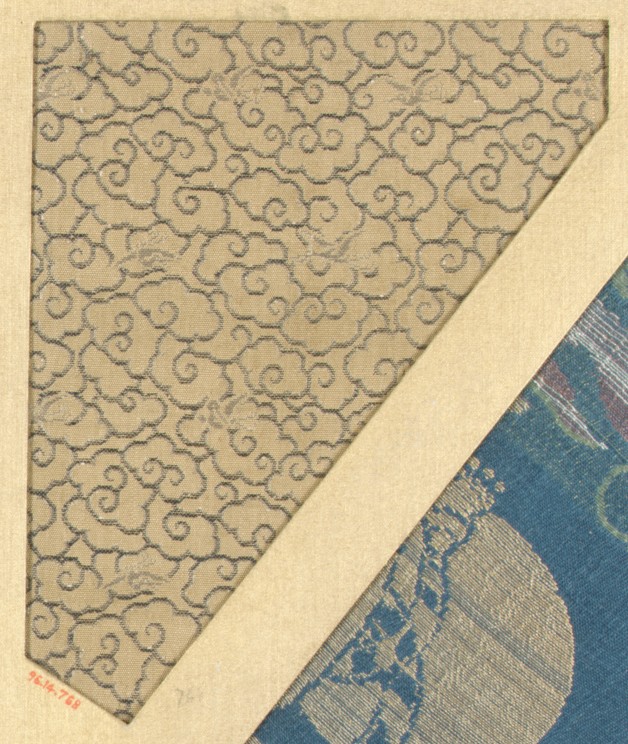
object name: piece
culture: japanese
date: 1701-1900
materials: silk